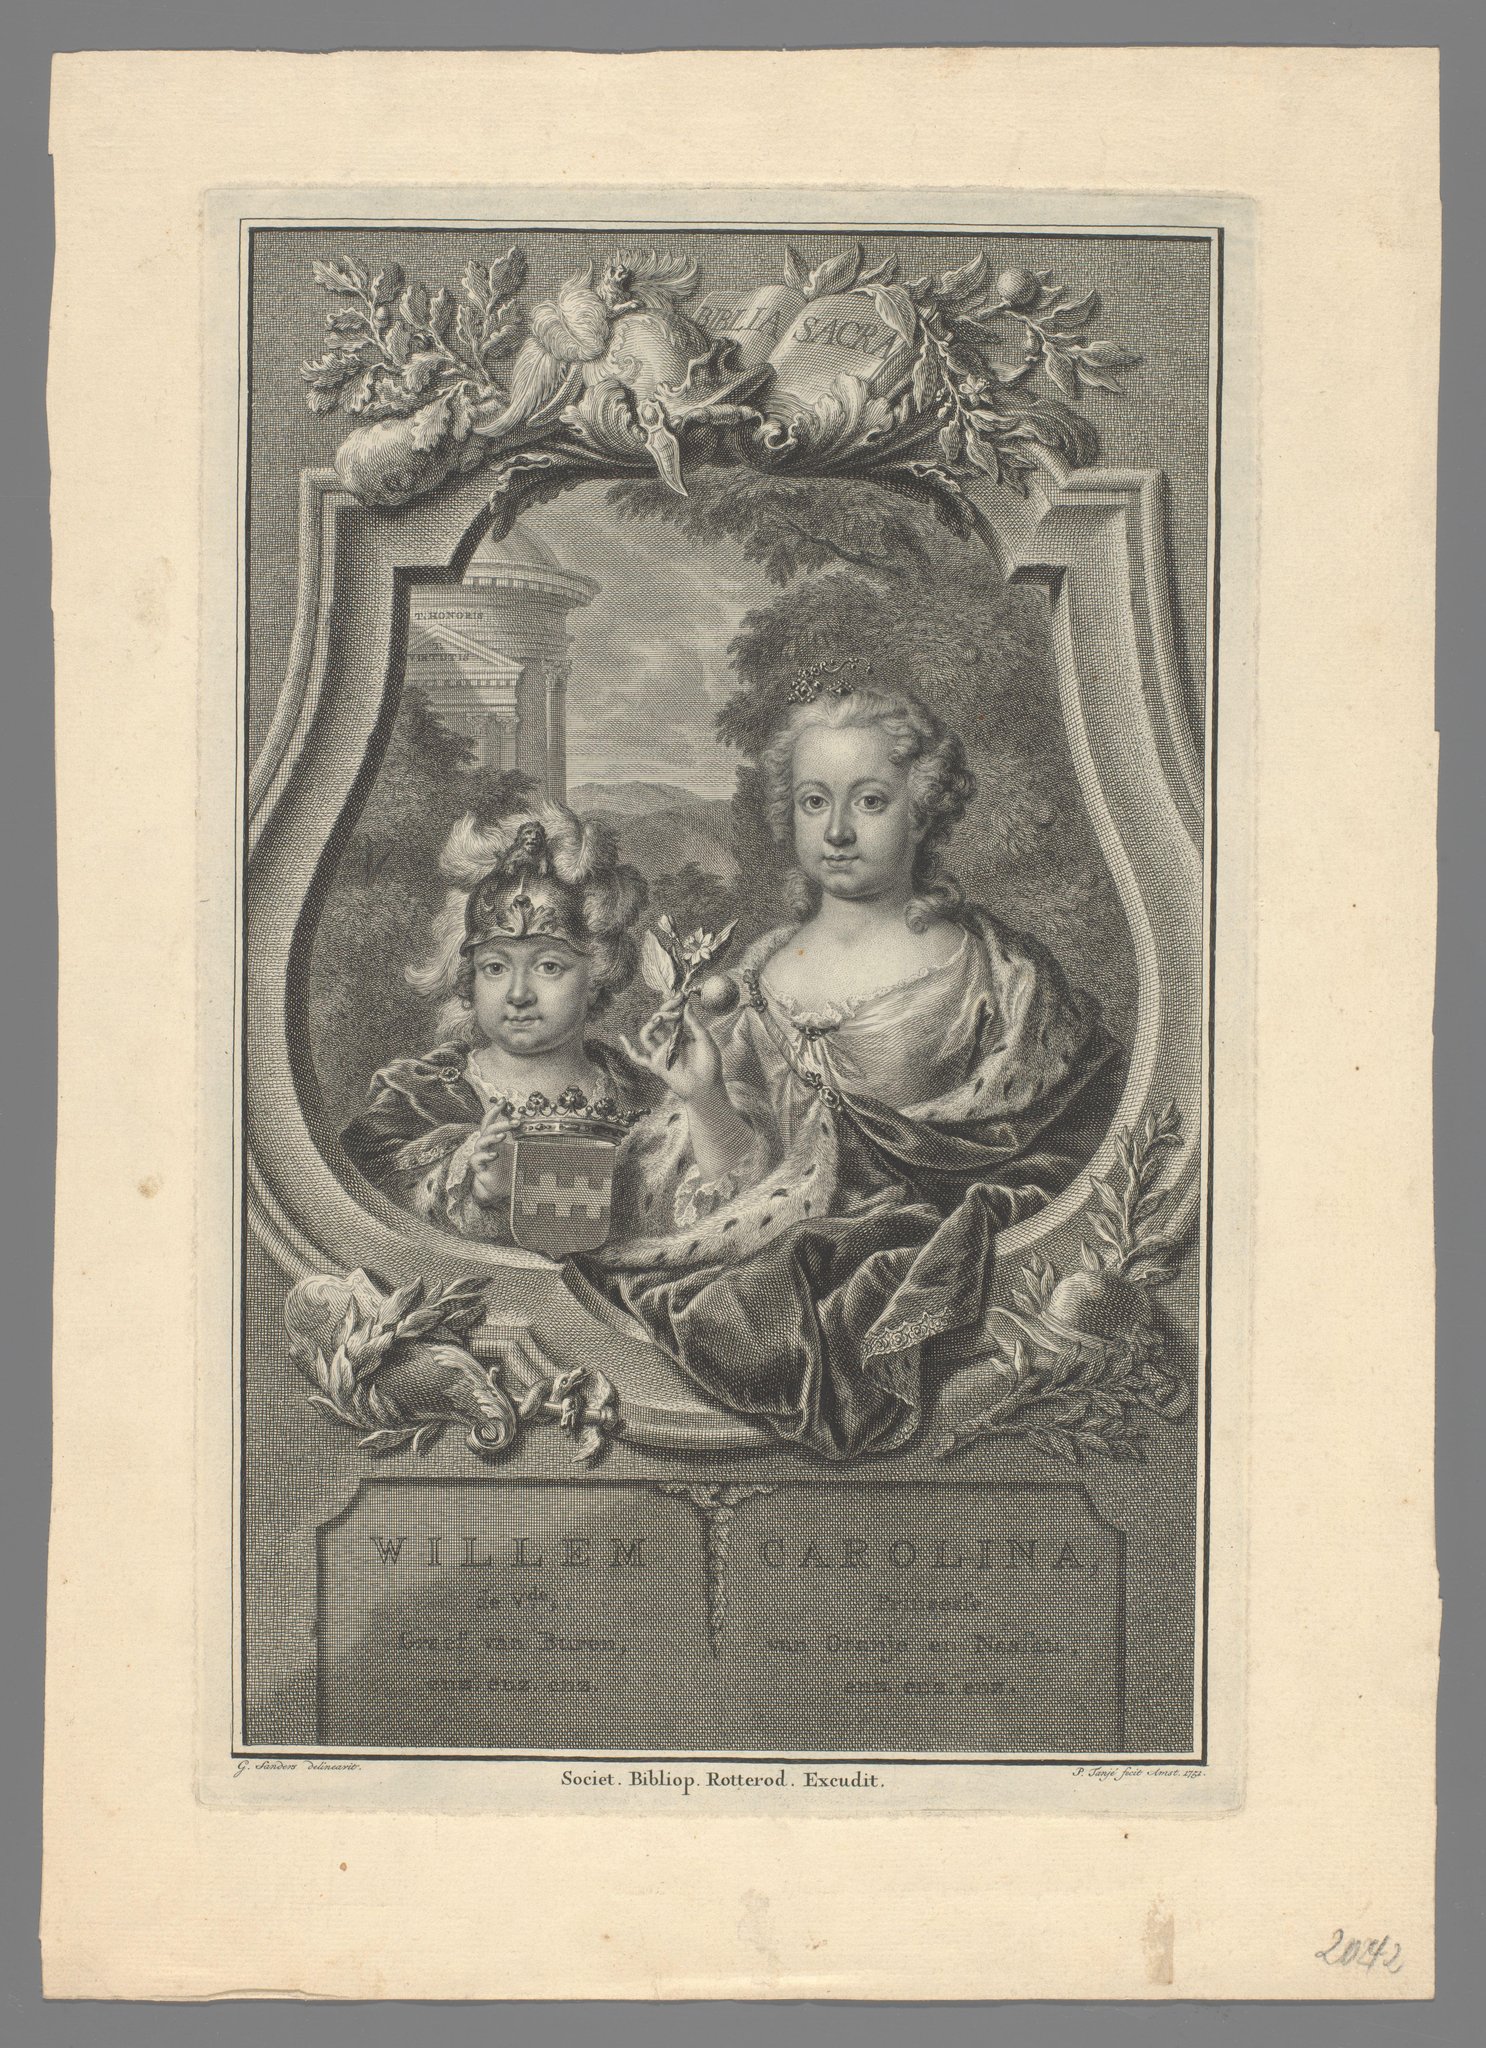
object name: print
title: Portret van Willem V, prins van Oranje-Nassau, en Carolina, prinses van Oranje-Nassau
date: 1751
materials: paper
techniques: engraving, etching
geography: rotterdam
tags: the hague, william v (prince of orange), carolina (prinses van oranje-nassau)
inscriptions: date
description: Portret van Willem V en Carolina onder een toog. In zijn rechterhand een wapen met een kroon. In haar rechterhand een oranjetak. Daar omheen een aantal allegorische objecten. Op een voetstuk hun namen en titels.